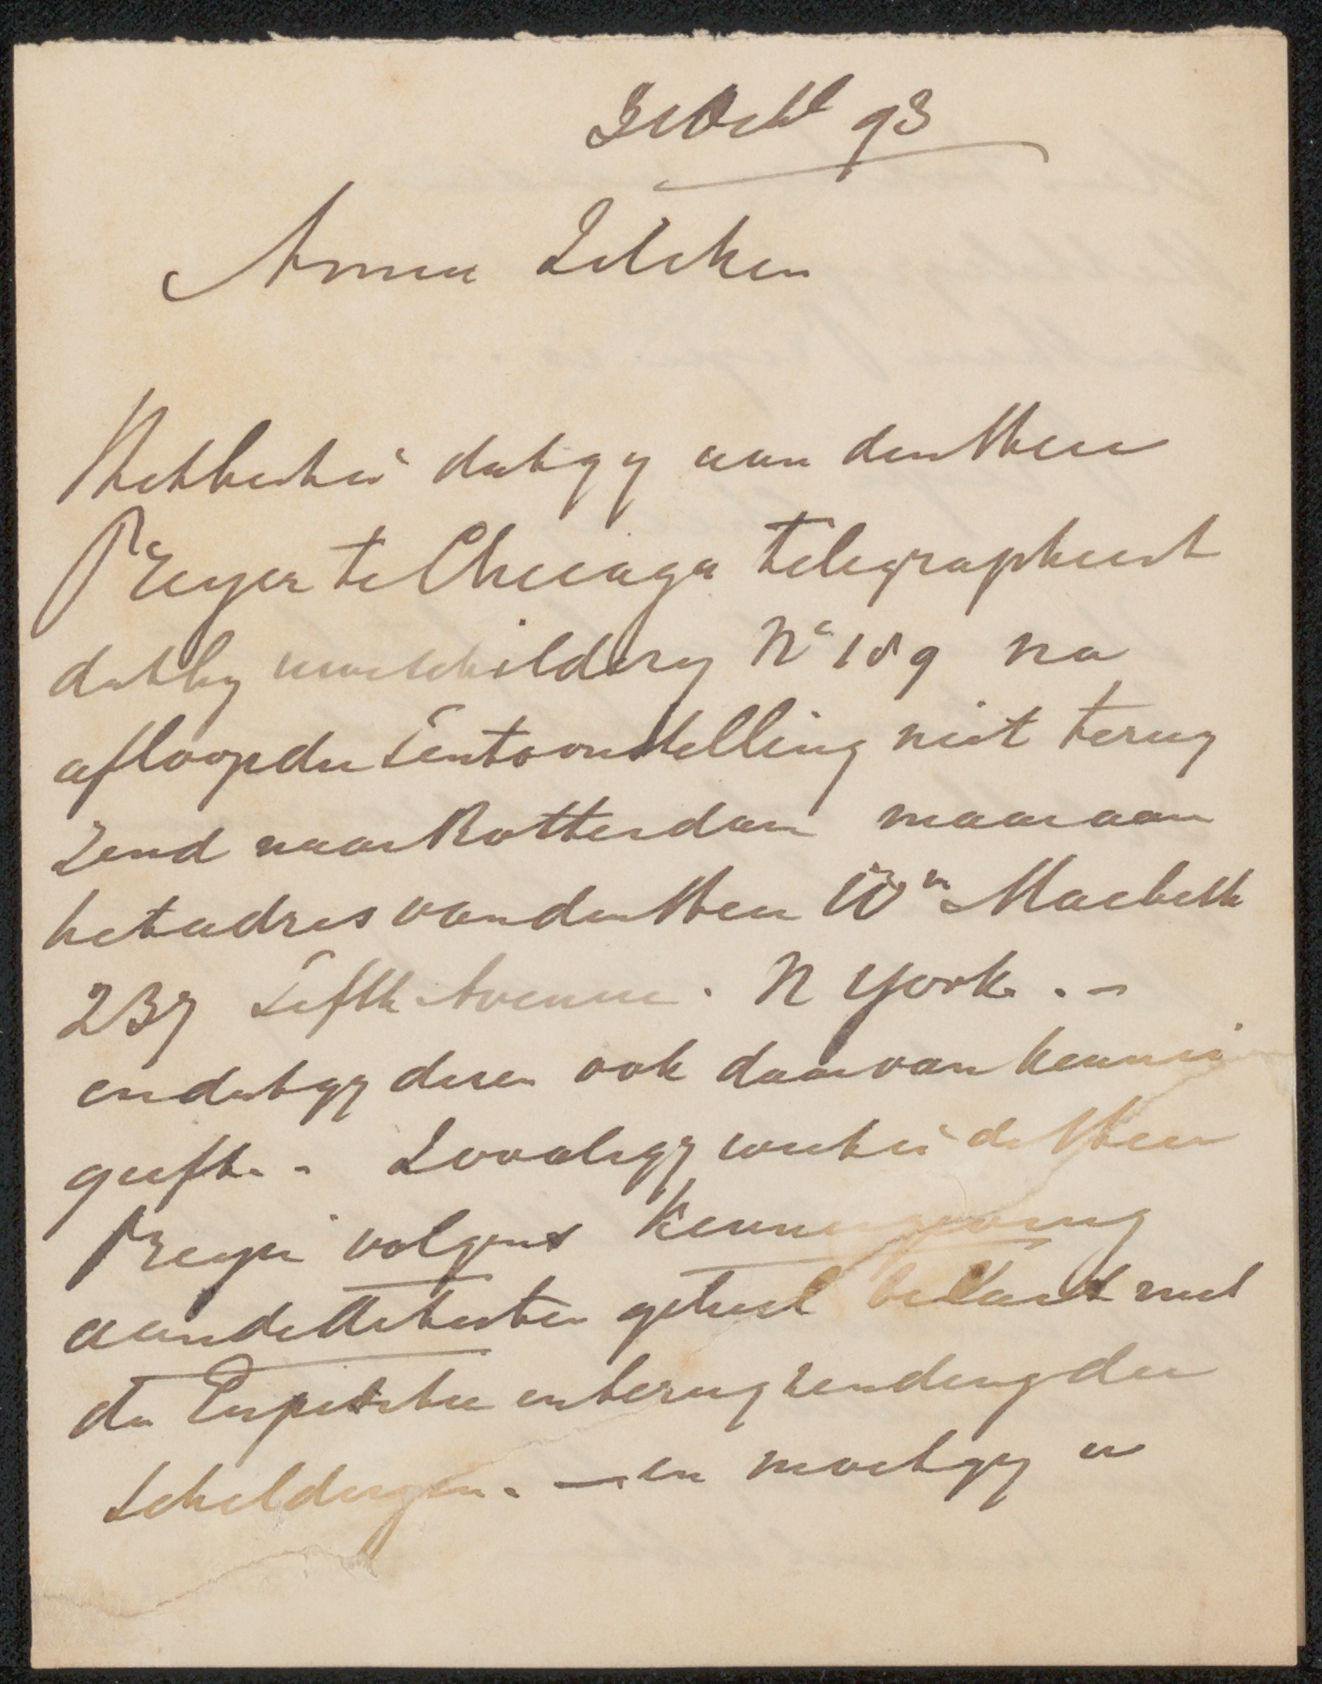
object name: letter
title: Brief aan Philip Zilcken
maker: hendrik willem mesdag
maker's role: draughtsman, painter, print maker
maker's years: 1831-1915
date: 1893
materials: ink, paper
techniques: pen, writing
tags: amsterdam, brussels, auctioneer, abraham preyer, william macbeth, philip zilcken, painting (including book-illumination, miniature-painting), exhibition ~ art, new york (city), rotterdam